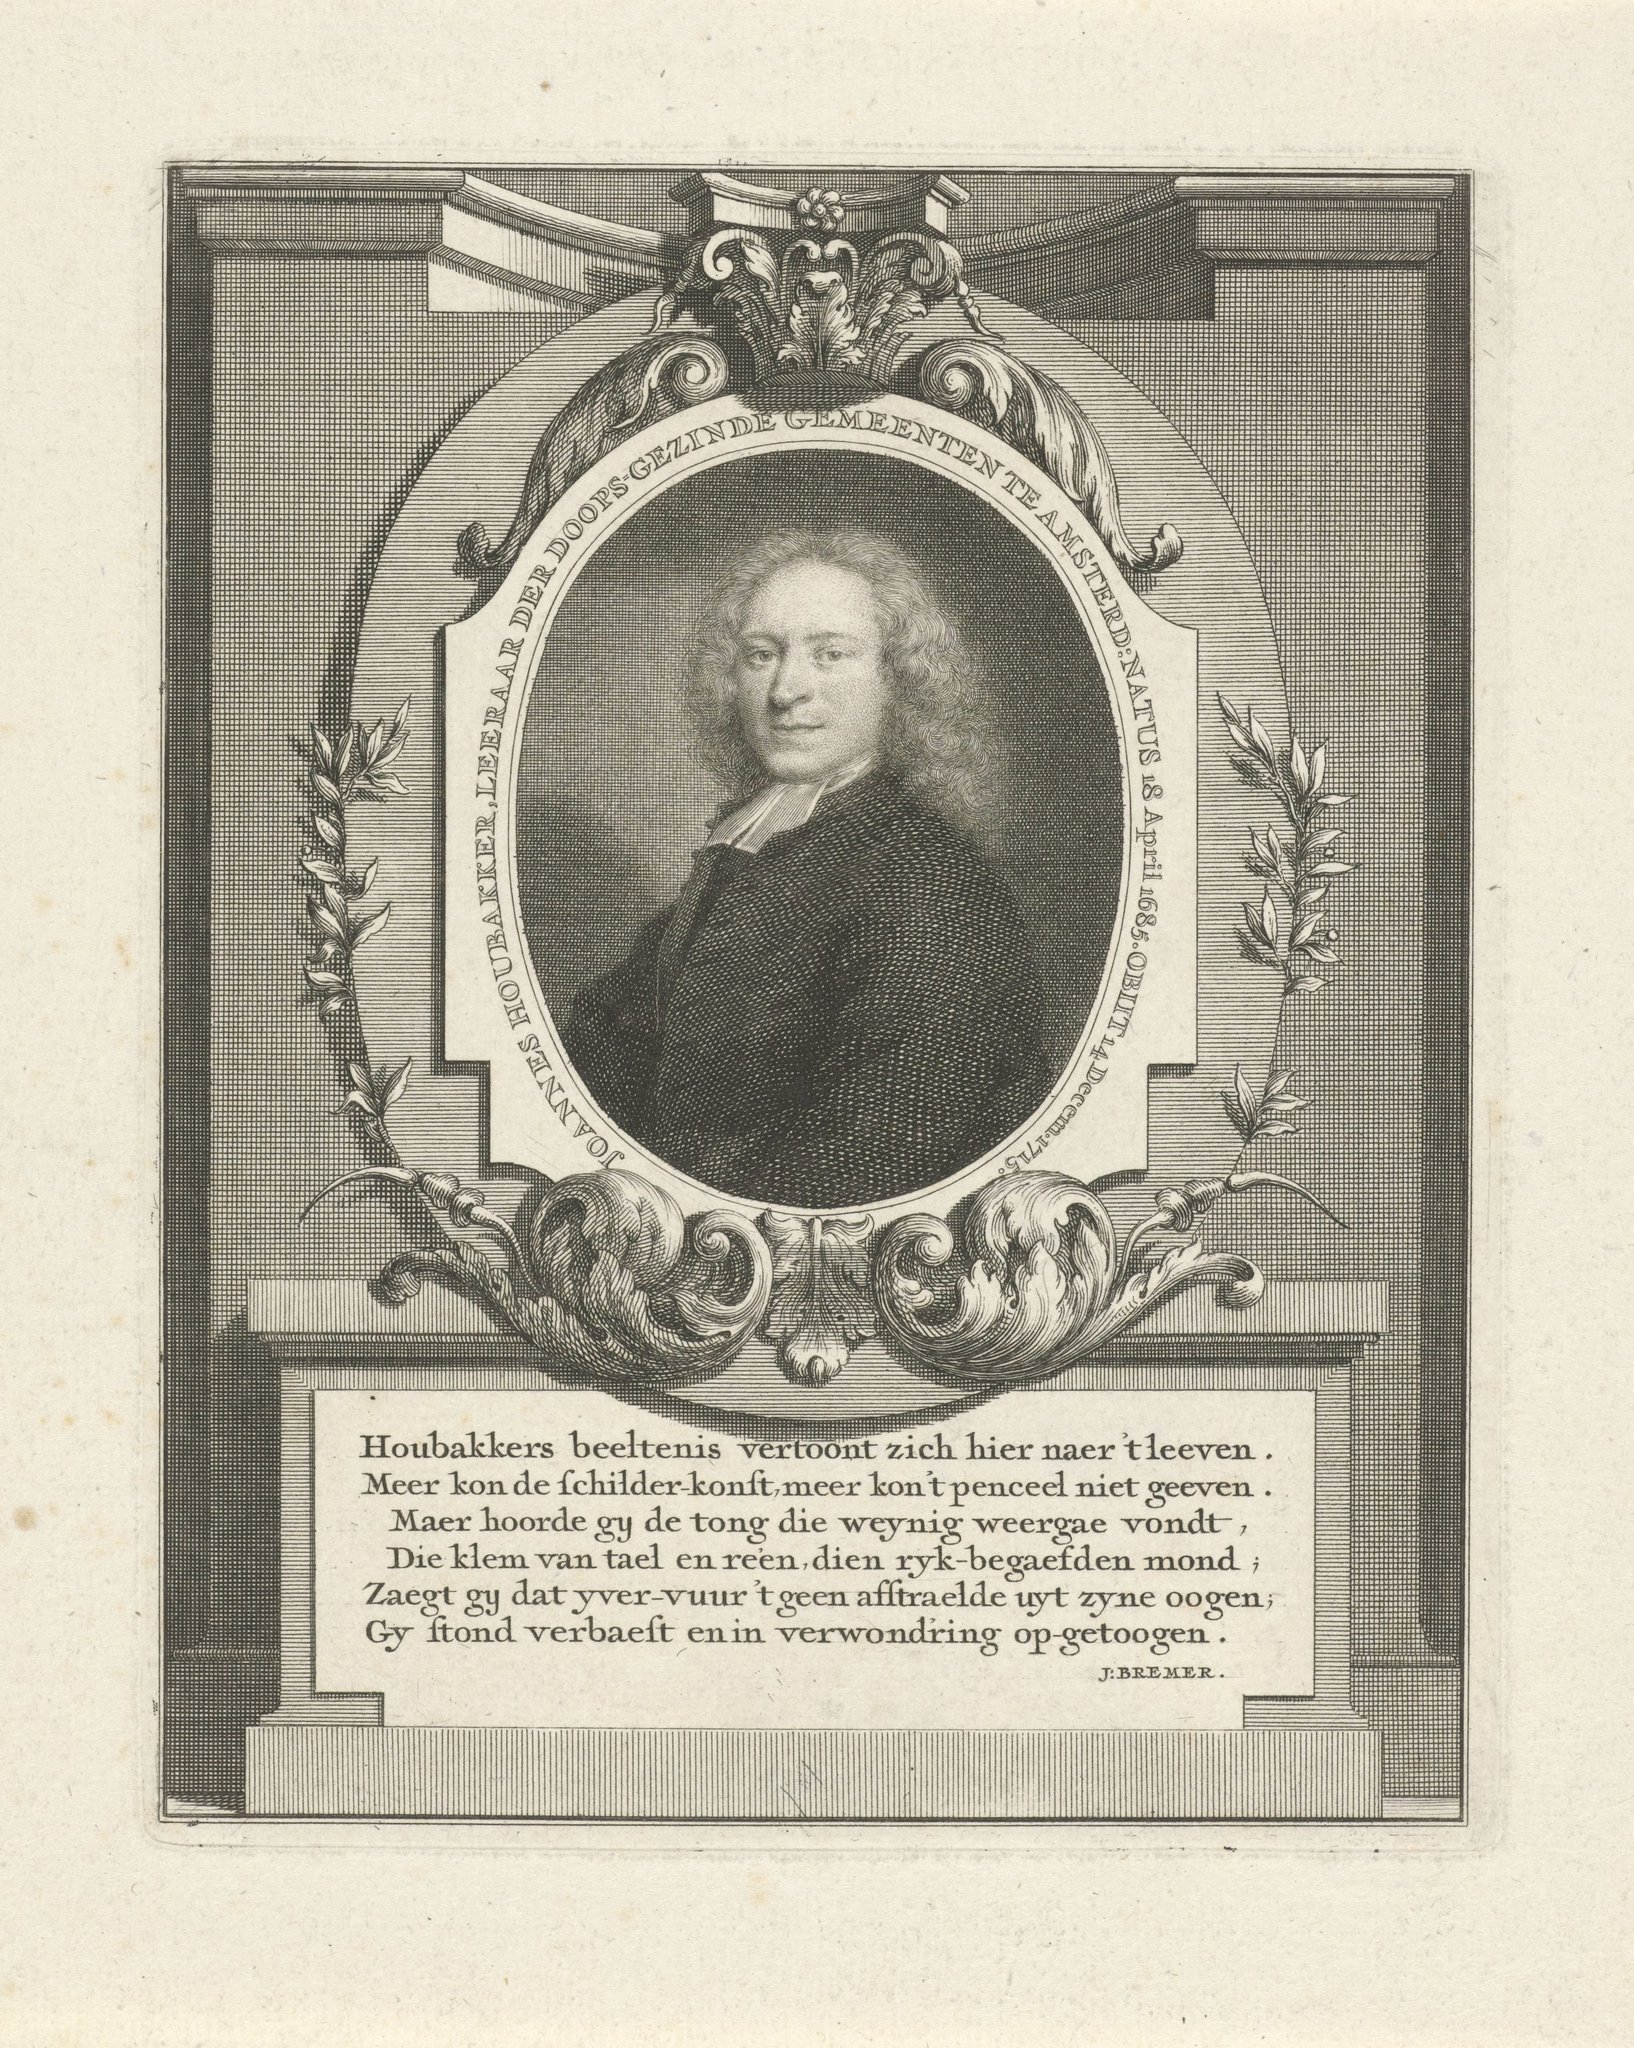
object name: print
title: Portret van Joannes Houbakker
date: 1715-1780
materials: paper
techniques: engraving, etching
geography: amsterdam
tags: joannes houbakker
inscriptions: collector's mark: Lugt 240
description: Portret naar links van Joannes Houbakker in een ornamenteel ovaal versierd met acanthusmotieven en met een randschrift in het Nederlands. Onder het portret een piëdestal met daarop een zesregelig vers in het Nederlands.